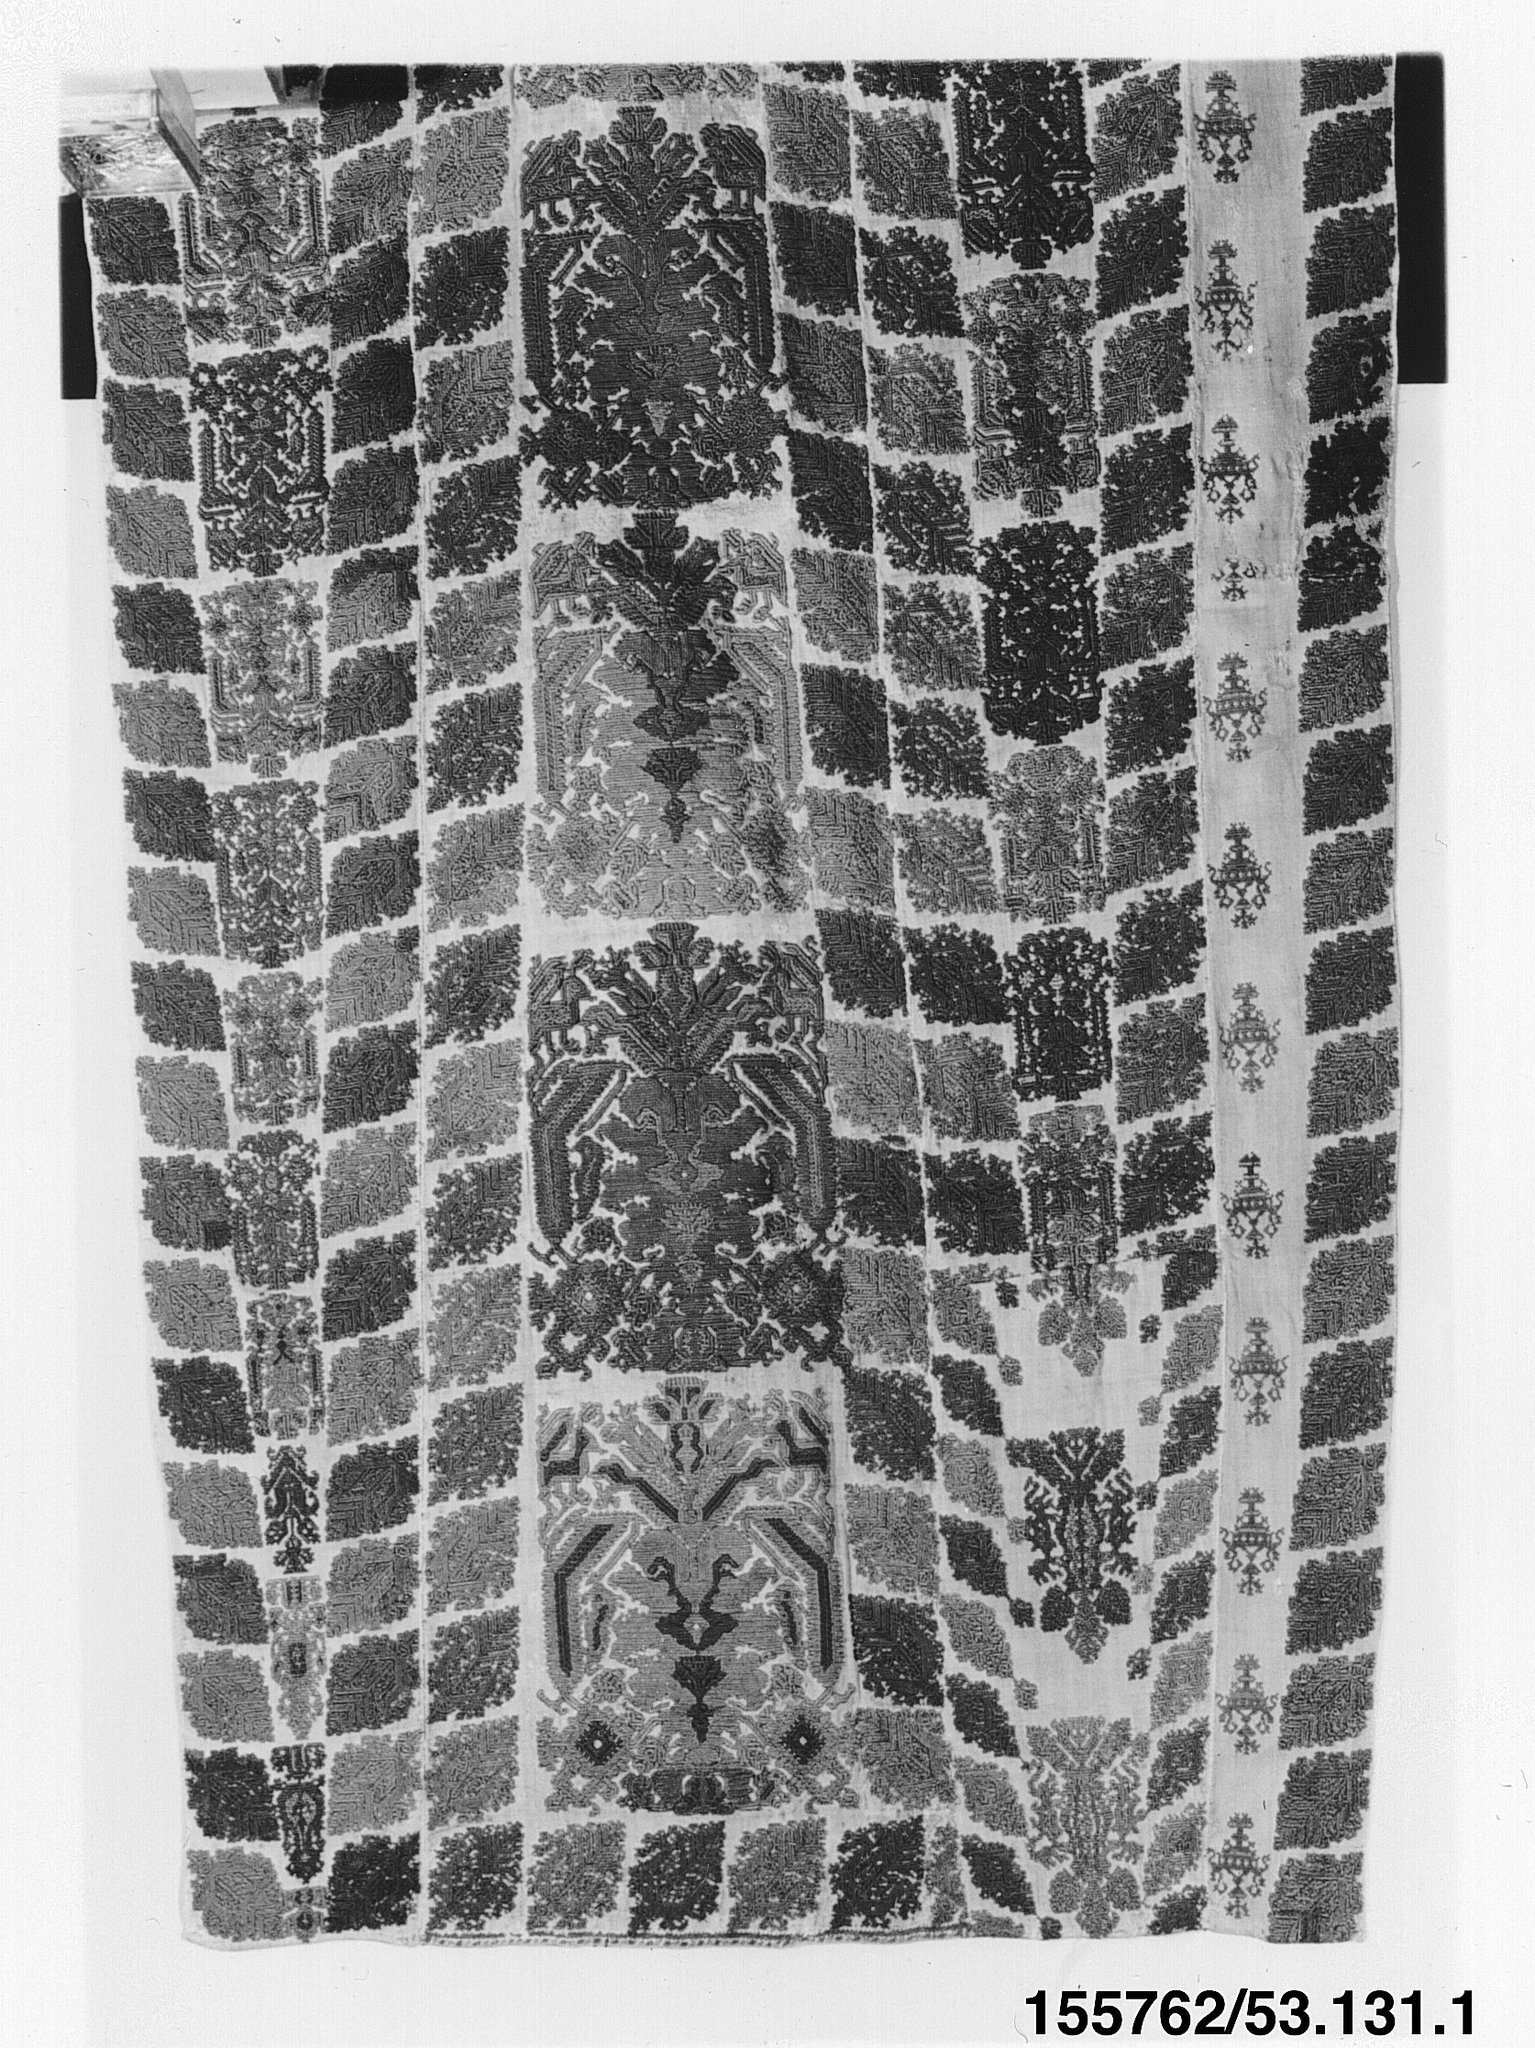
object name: bed tent panel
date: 1701-1800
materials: linen, silk